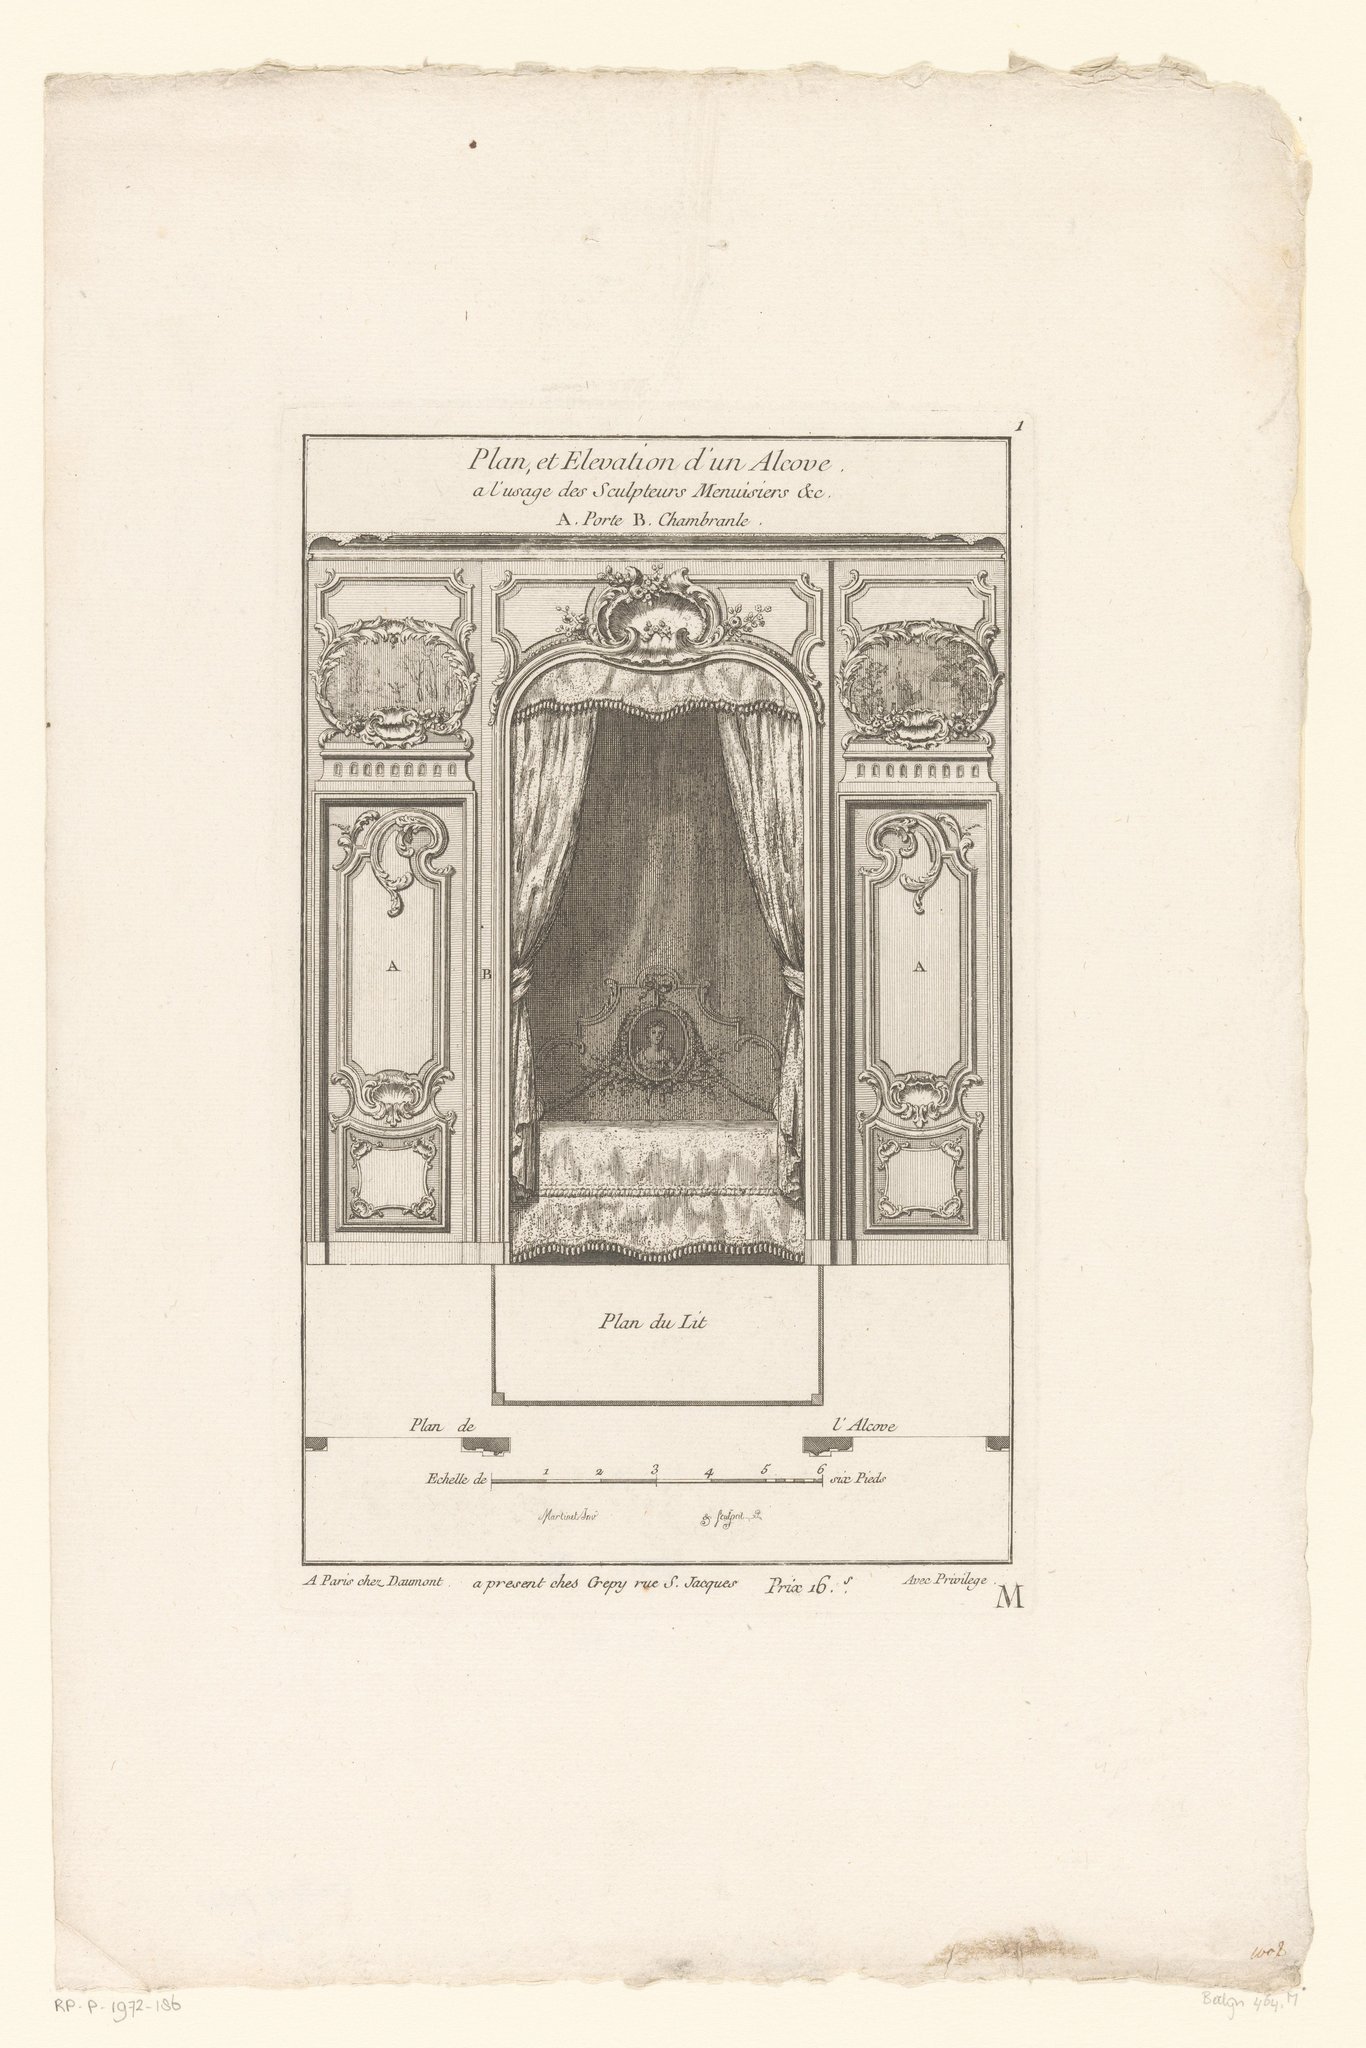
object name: ornament print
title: M Alkoven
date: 1745-1775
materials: paper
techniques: engraving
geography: paris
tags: built-in bedstead (dutch: 'bedstee')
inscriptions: collector's mark: Lugt 2760, collector's mark: Lugt 2228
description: Plattegrond en vooraanzicht van een alkoof met gordijnen en een bed met medaillon met vrouwenportret. Aan weerszijden van de alkoof rocaille panelen en een afbeelding van een landschap.